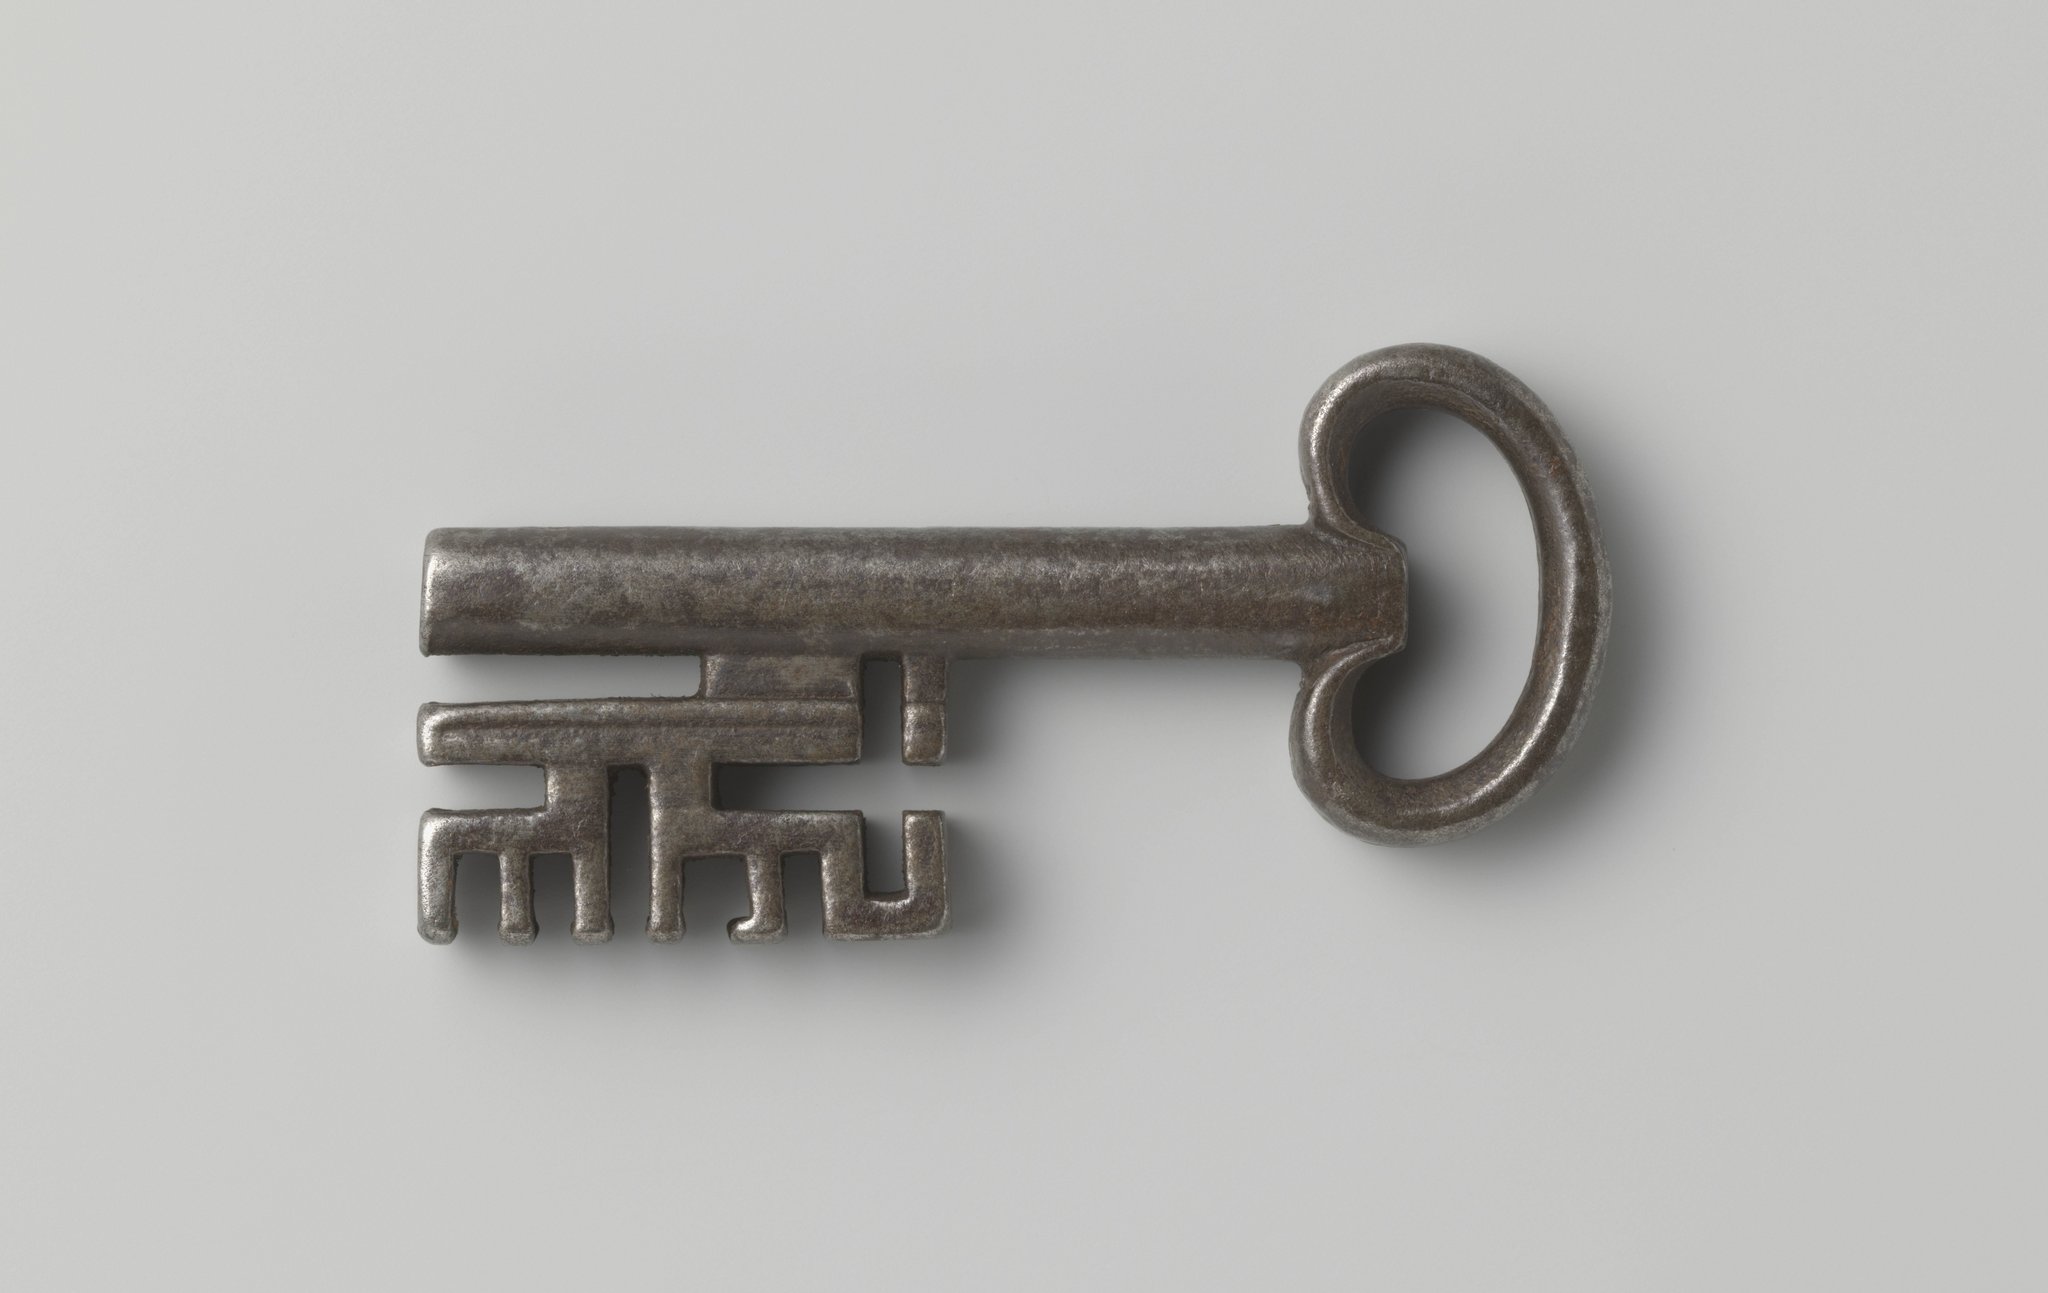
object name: pipe key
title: Pijpsleutel, metaal, ring boonvormig gebogen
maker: Anonymous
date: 1400-1500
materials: bronze, metal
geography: france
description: Pijpsleutel, porselein, ring boonvormig gebogen, met gedetailleerde en opengetande baard.